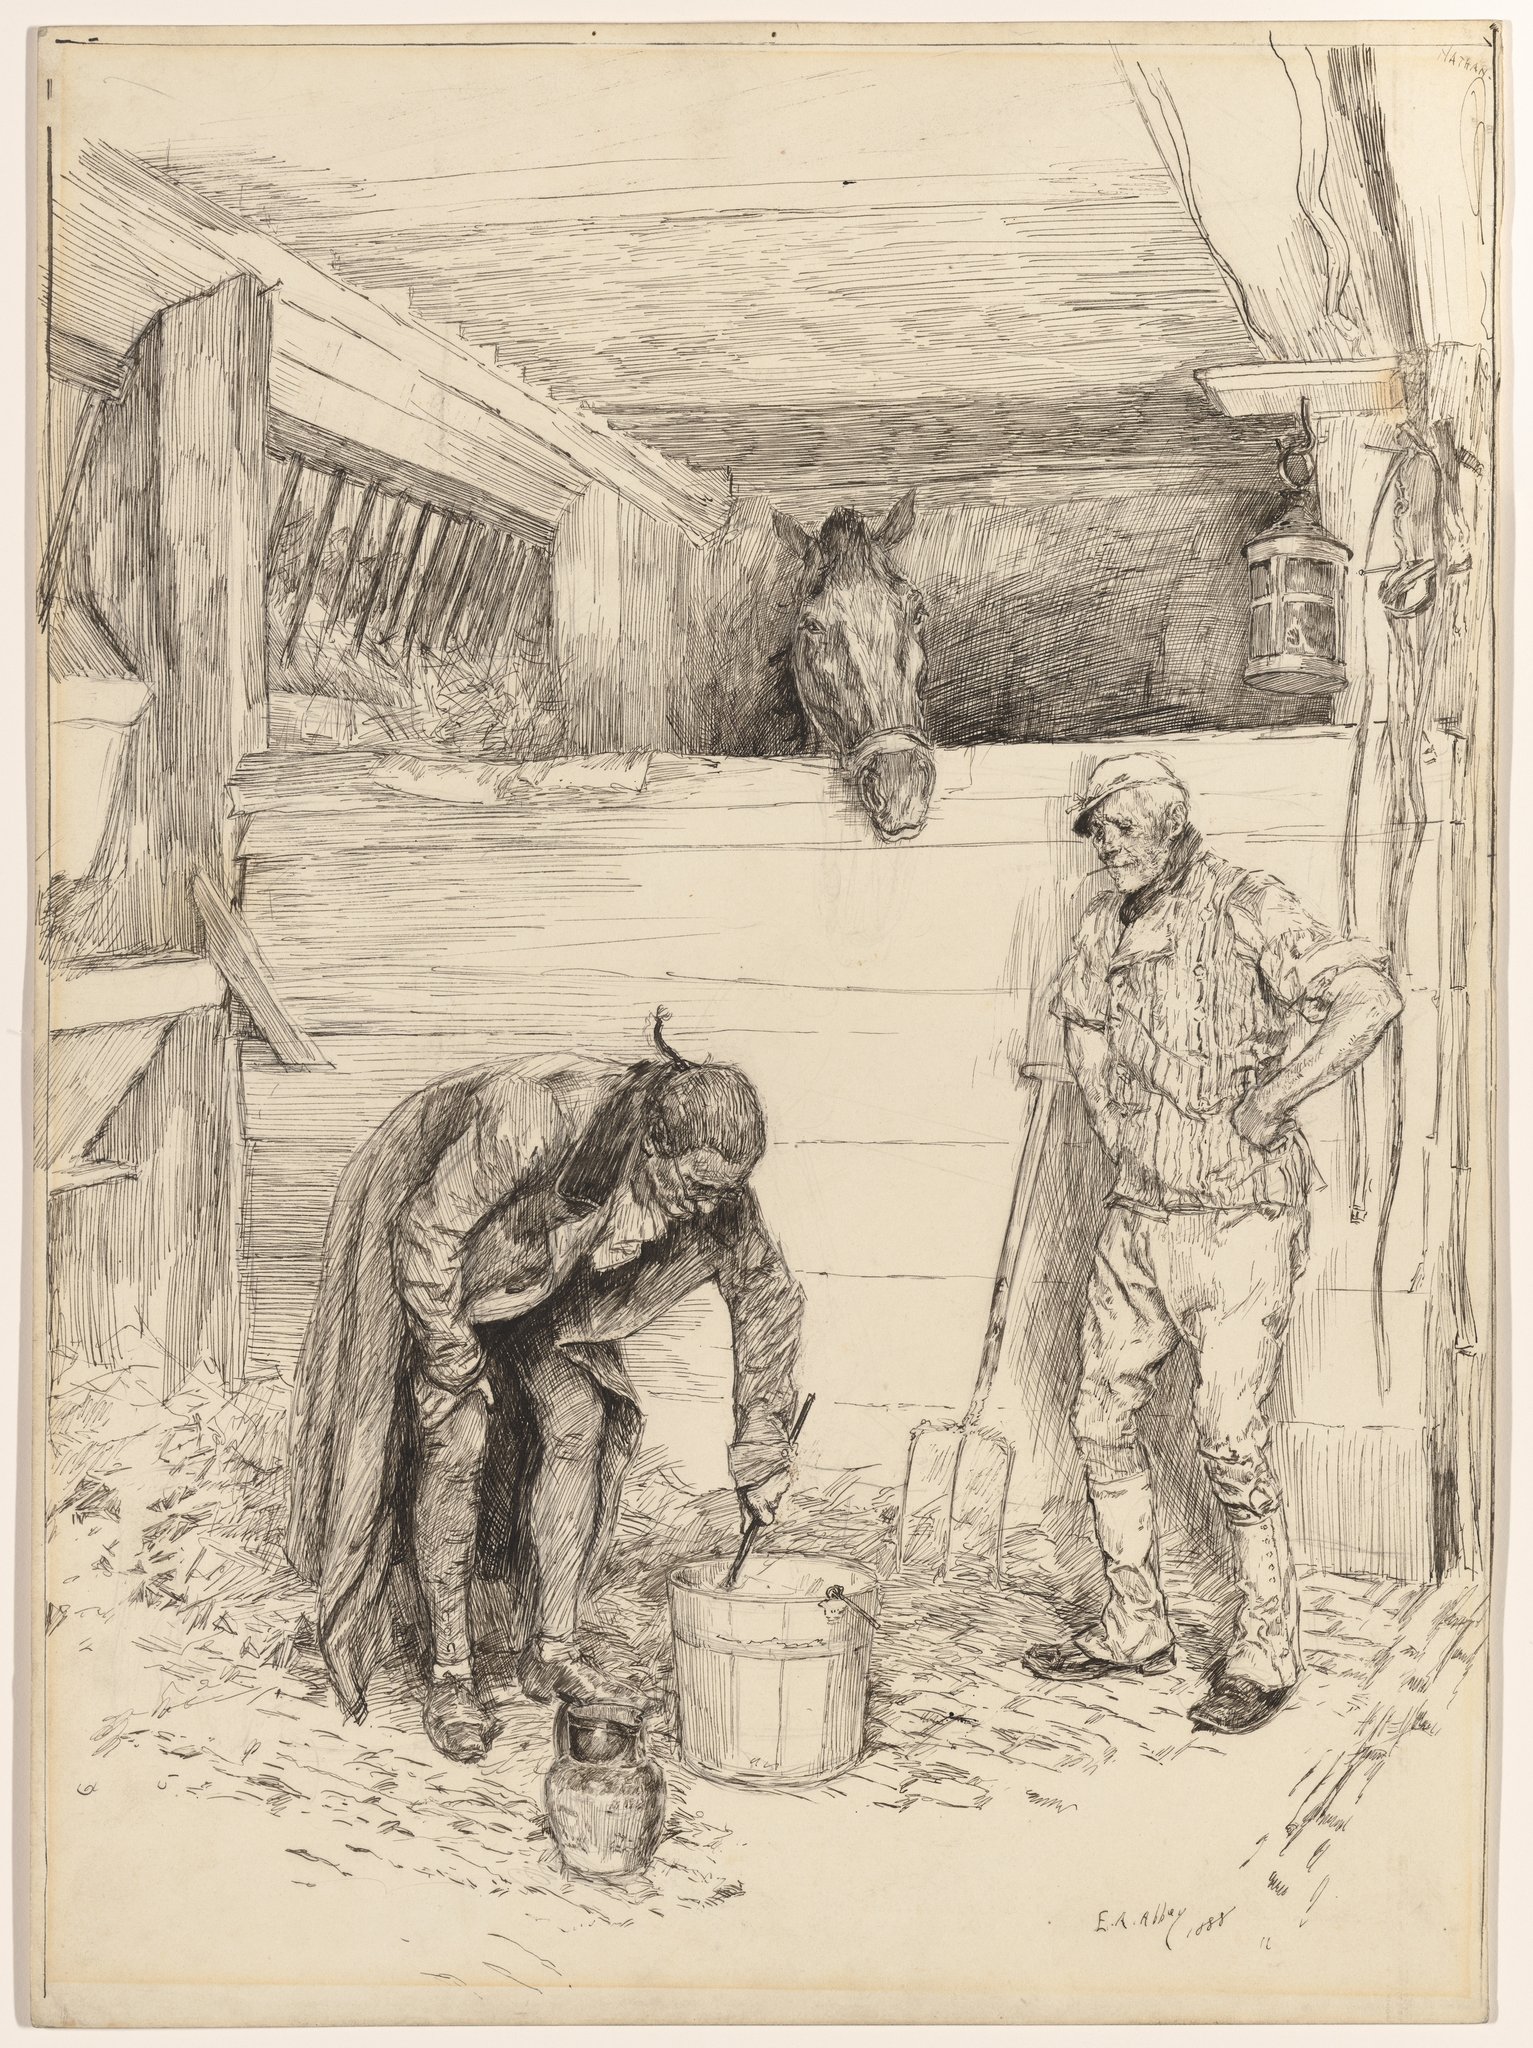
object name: drawing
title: And none knew why he fed them both with his own hands, illustration to "Quince"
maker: edwin austin abbey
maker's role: artist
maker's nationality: american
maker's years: 1852-1911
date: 1888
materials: cardboard, ink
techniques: pen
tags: men,horses,working